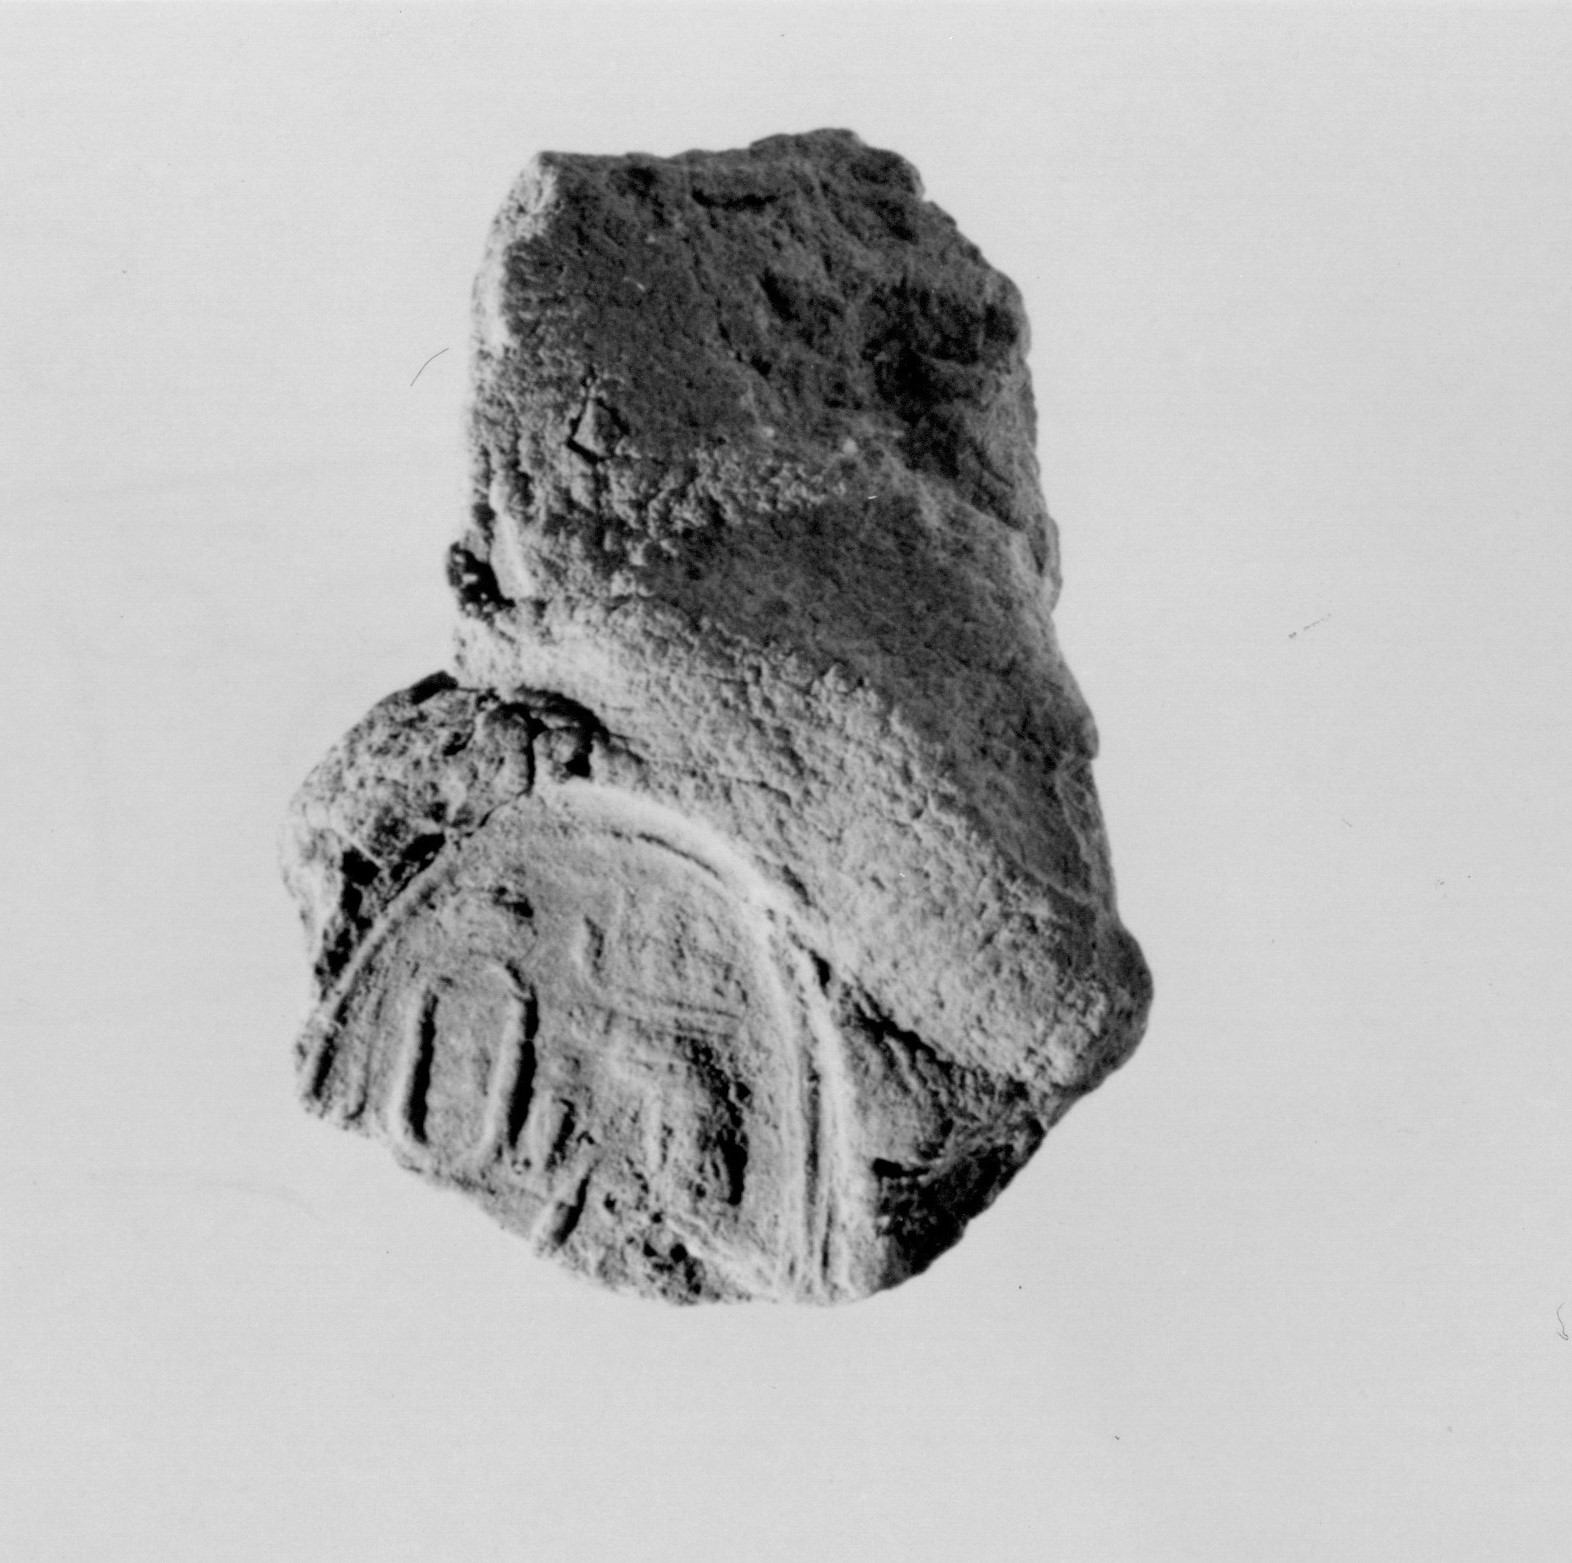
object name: sealing, nebmaatre, amenhotep iii,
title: Document Sealing With the Throne Name of Amenhotep III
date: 1390-1352 BCE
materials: mud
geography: egypt